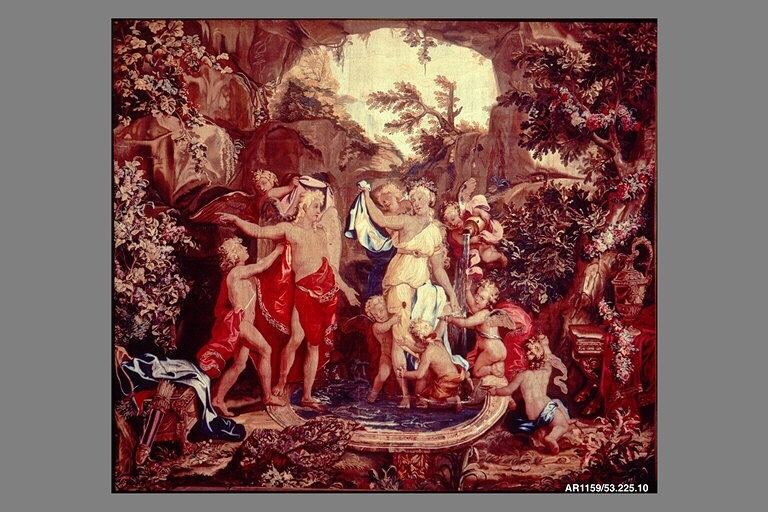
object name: tapestry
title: Cupid and Psyche Bathing from a set of Mythological Subjects after Giulio Romano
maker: giulio romano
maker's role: artist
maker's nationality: italian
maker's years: 1499-1546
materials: metal thread, silk, wool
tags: cupid,psyche,bathing